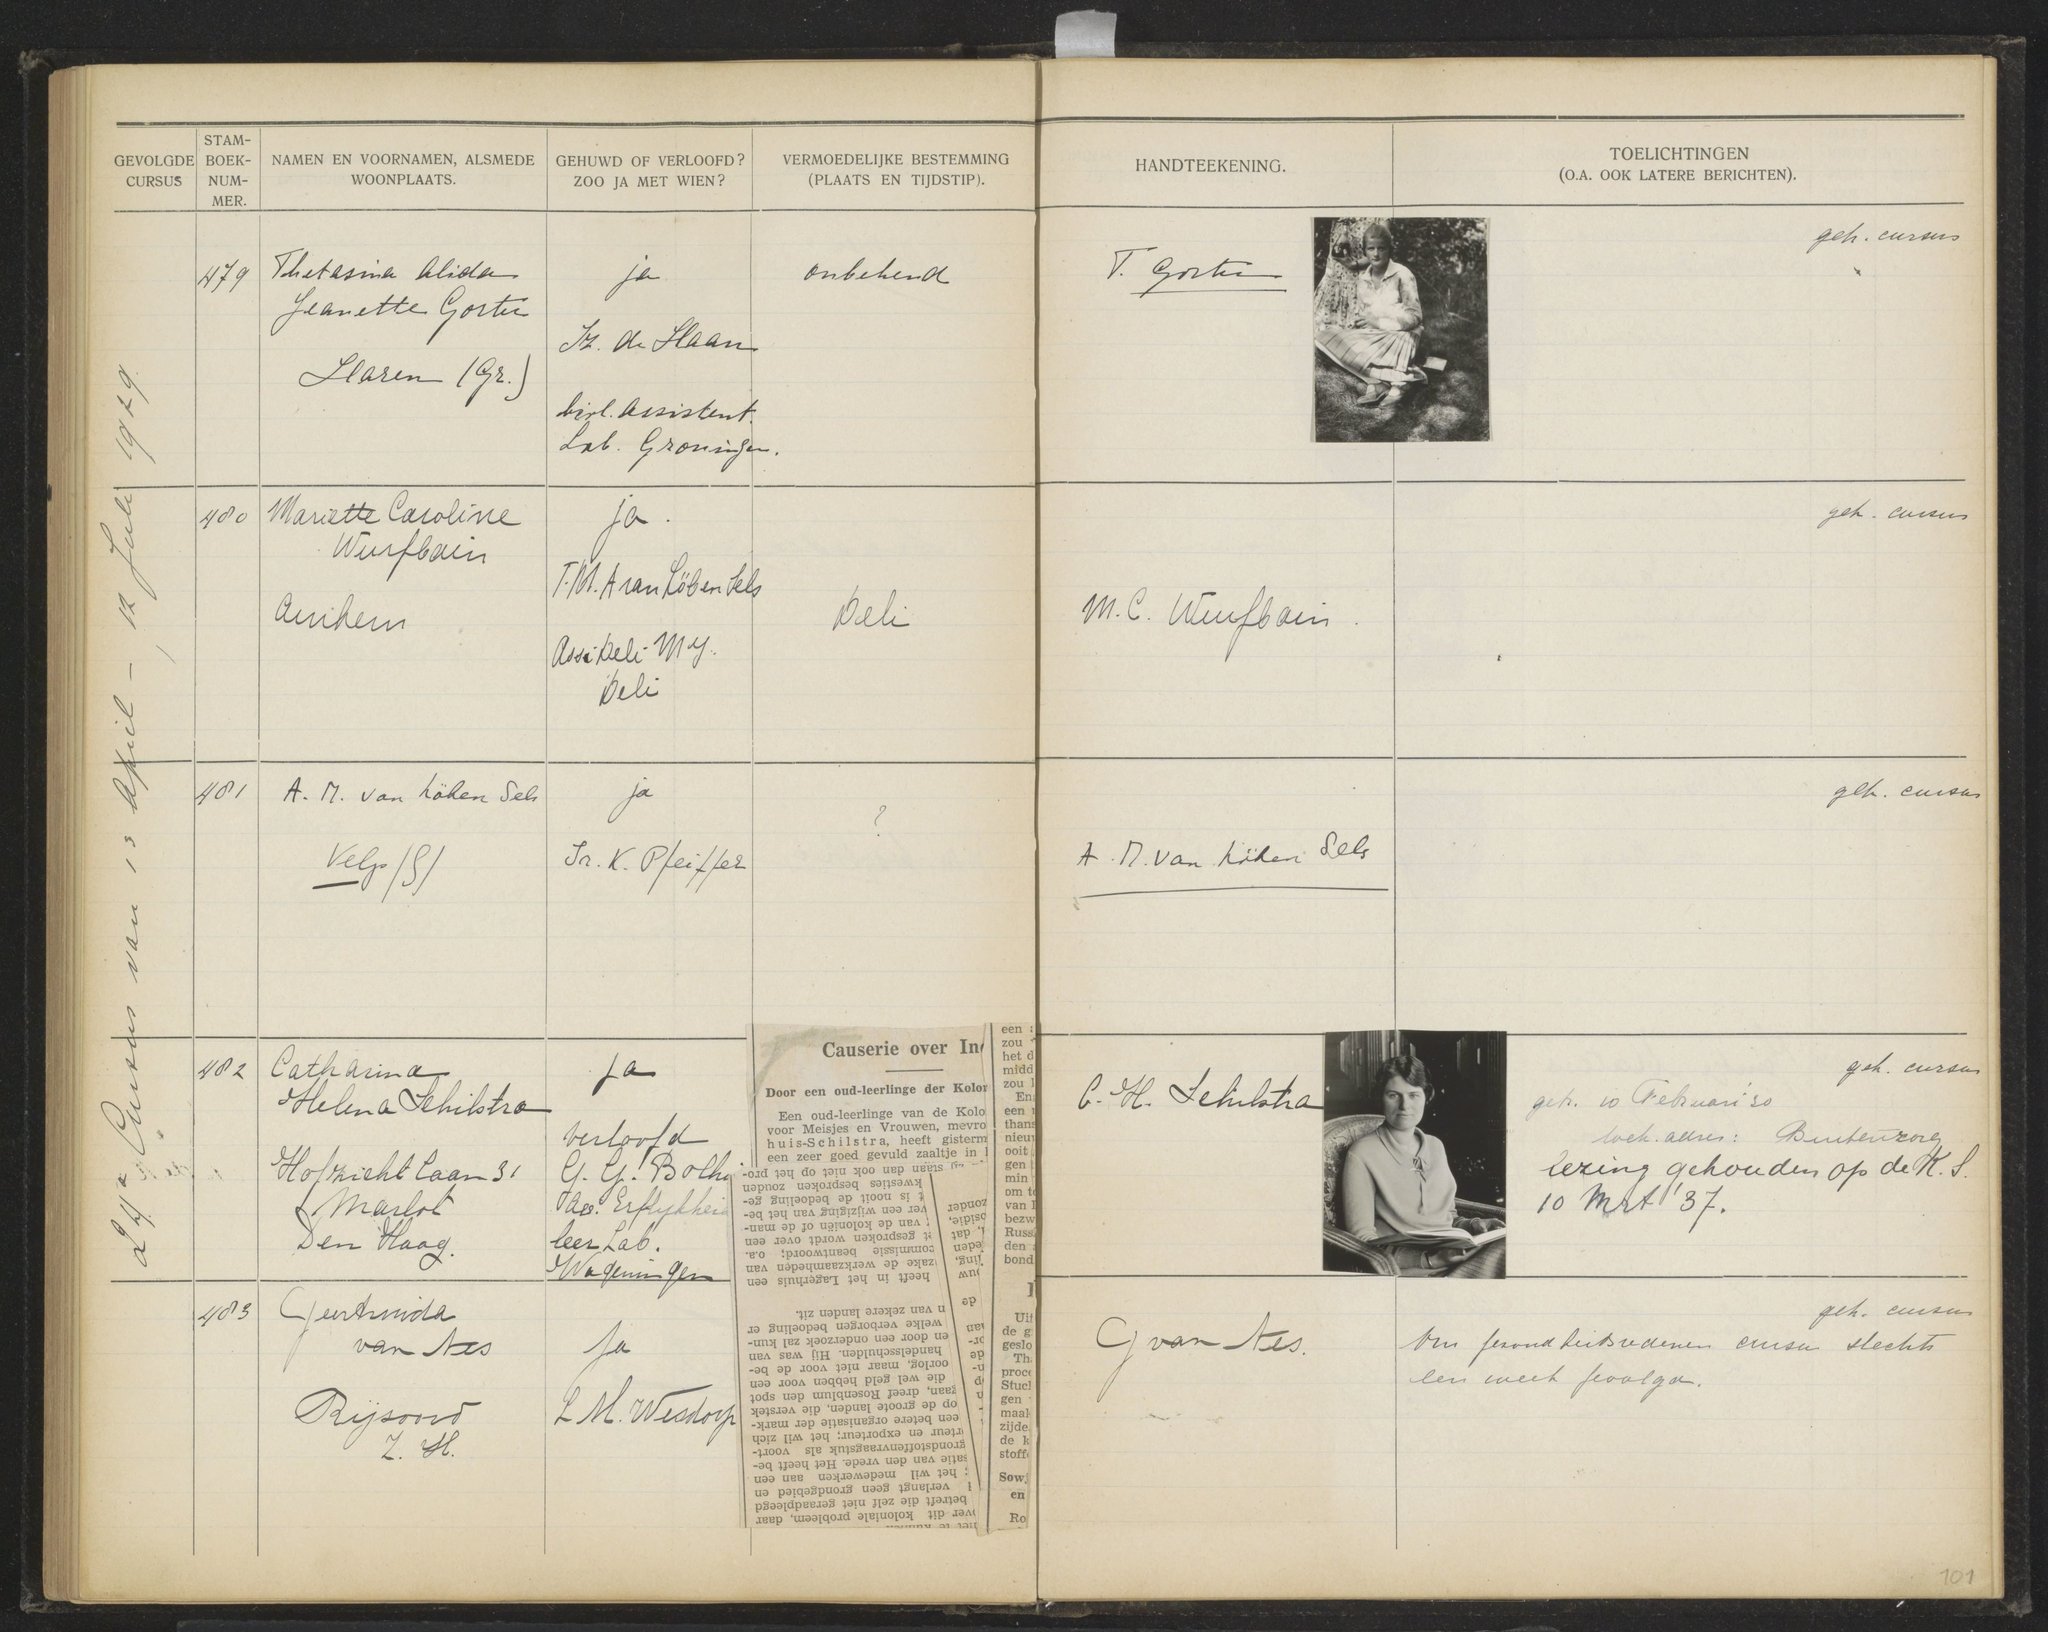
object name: photograph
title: Blad 101 uit Stamboek van de leerlingen der Koloniale School voor Meisjes en Vrouwen te 's-Gravenhage deel I (1921-1929)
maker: Anonymous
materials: paper, photographic support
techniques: photography, printing, writing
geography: the hague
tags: further education (+ pupil), further education, the hague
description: Twee pagina's met gegevens van de deelnemers aan de 24e driemaandelijkse cursus van 15 april tot en met 12 juli 1929, stamboeknummers 479 tot en met 483. Onderdeel van Stamboek van de leerlingen der Koloniale School voor Meisjes en Vrouwen te 's-Gravenhage deel I (1921-1929).